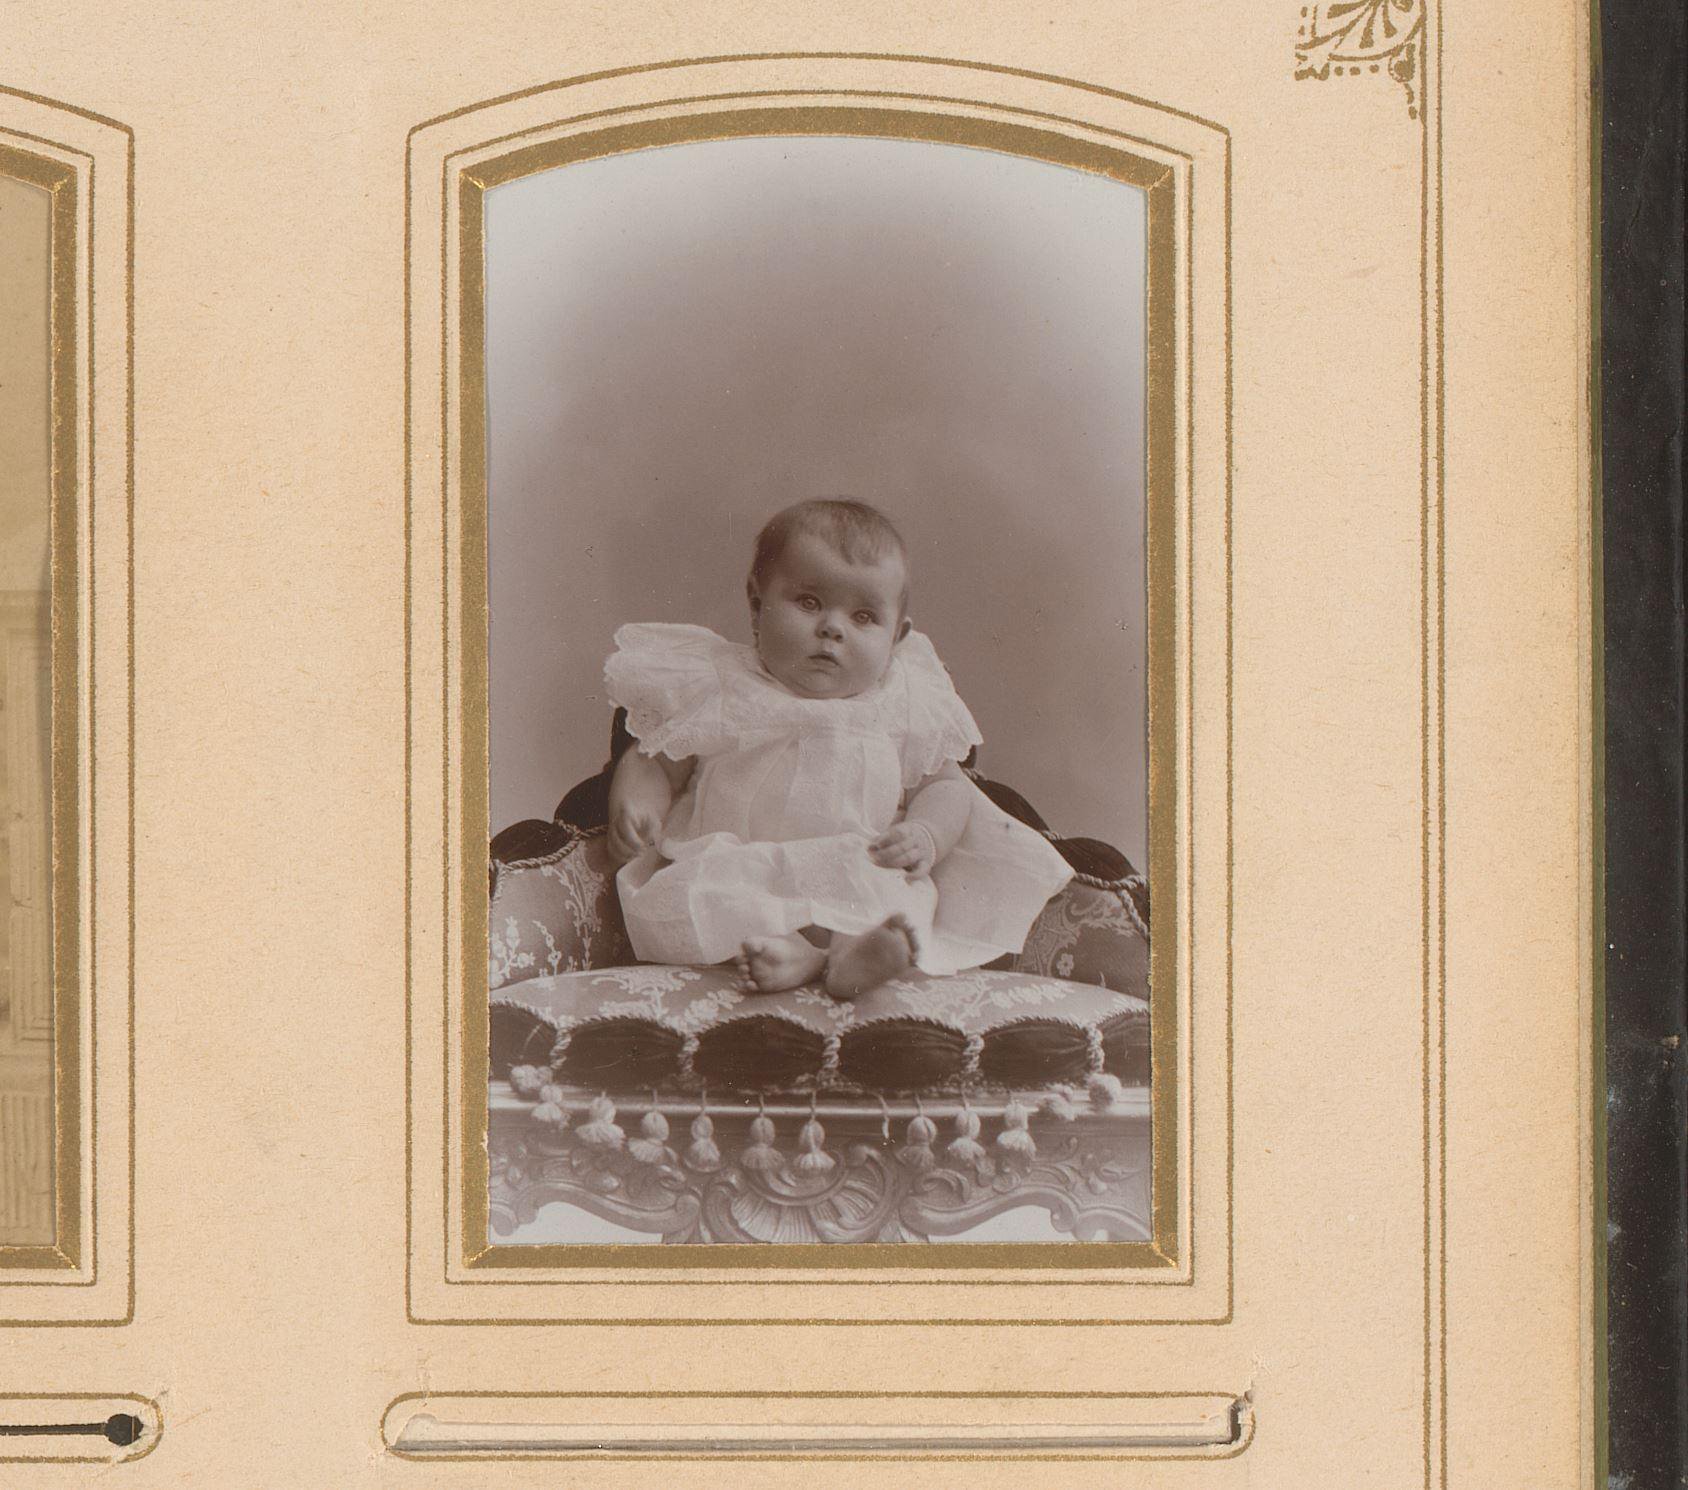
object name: album leaf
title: Portret van een zittende baby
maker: machiel hendricus laddé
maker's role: fotograaf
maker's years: 1866-1932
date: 1892-1906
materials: cardboard, photographic support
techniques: collodion silver print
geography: amsterdam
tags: sitting figure - aa - female human figure, historical persons - bb - woman, infant, baby ~ the ages of man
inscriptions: inscription: ‘No.../ Photographie/ Artistique/ M H Laddé/ BOVEN DE FIRMA/ MERKELBACH & Co/ AMSTERDAM/ 57-59/ NIEUWENDIJK/ Het Cliche wordt voor verdere bestellingen bewaard.’